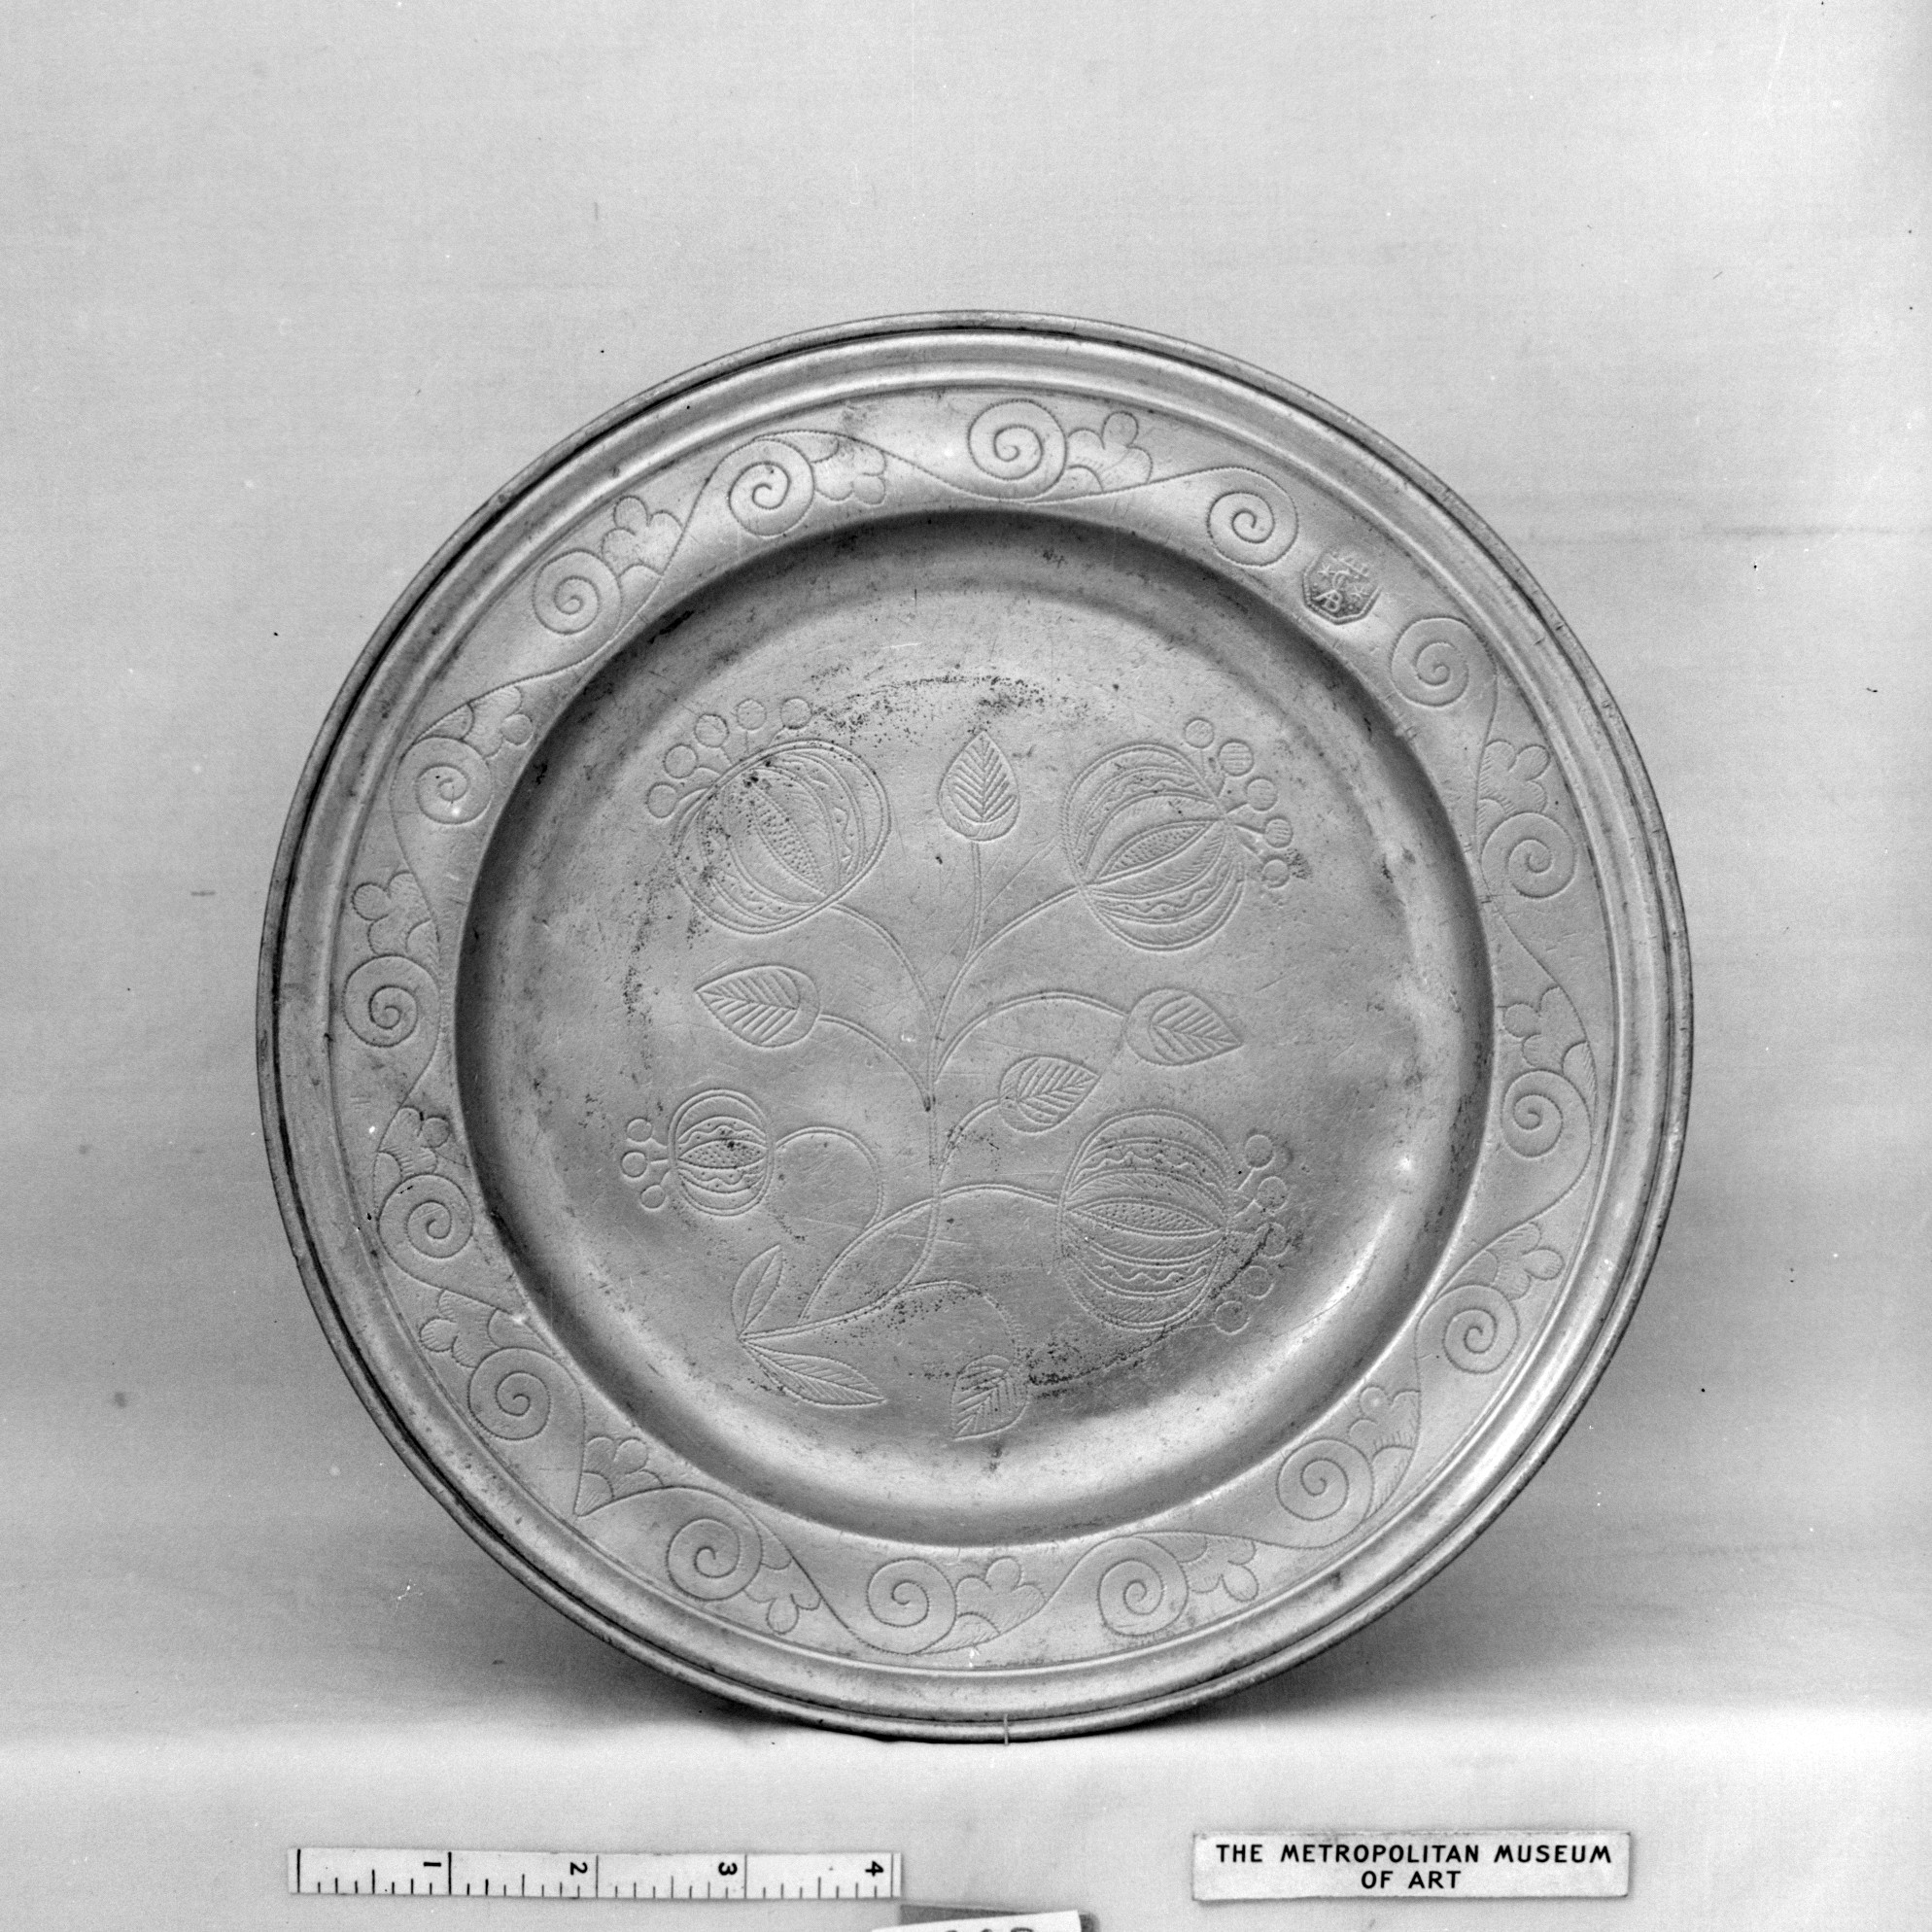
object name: plate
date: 1701-1800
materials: pewter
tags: flowers